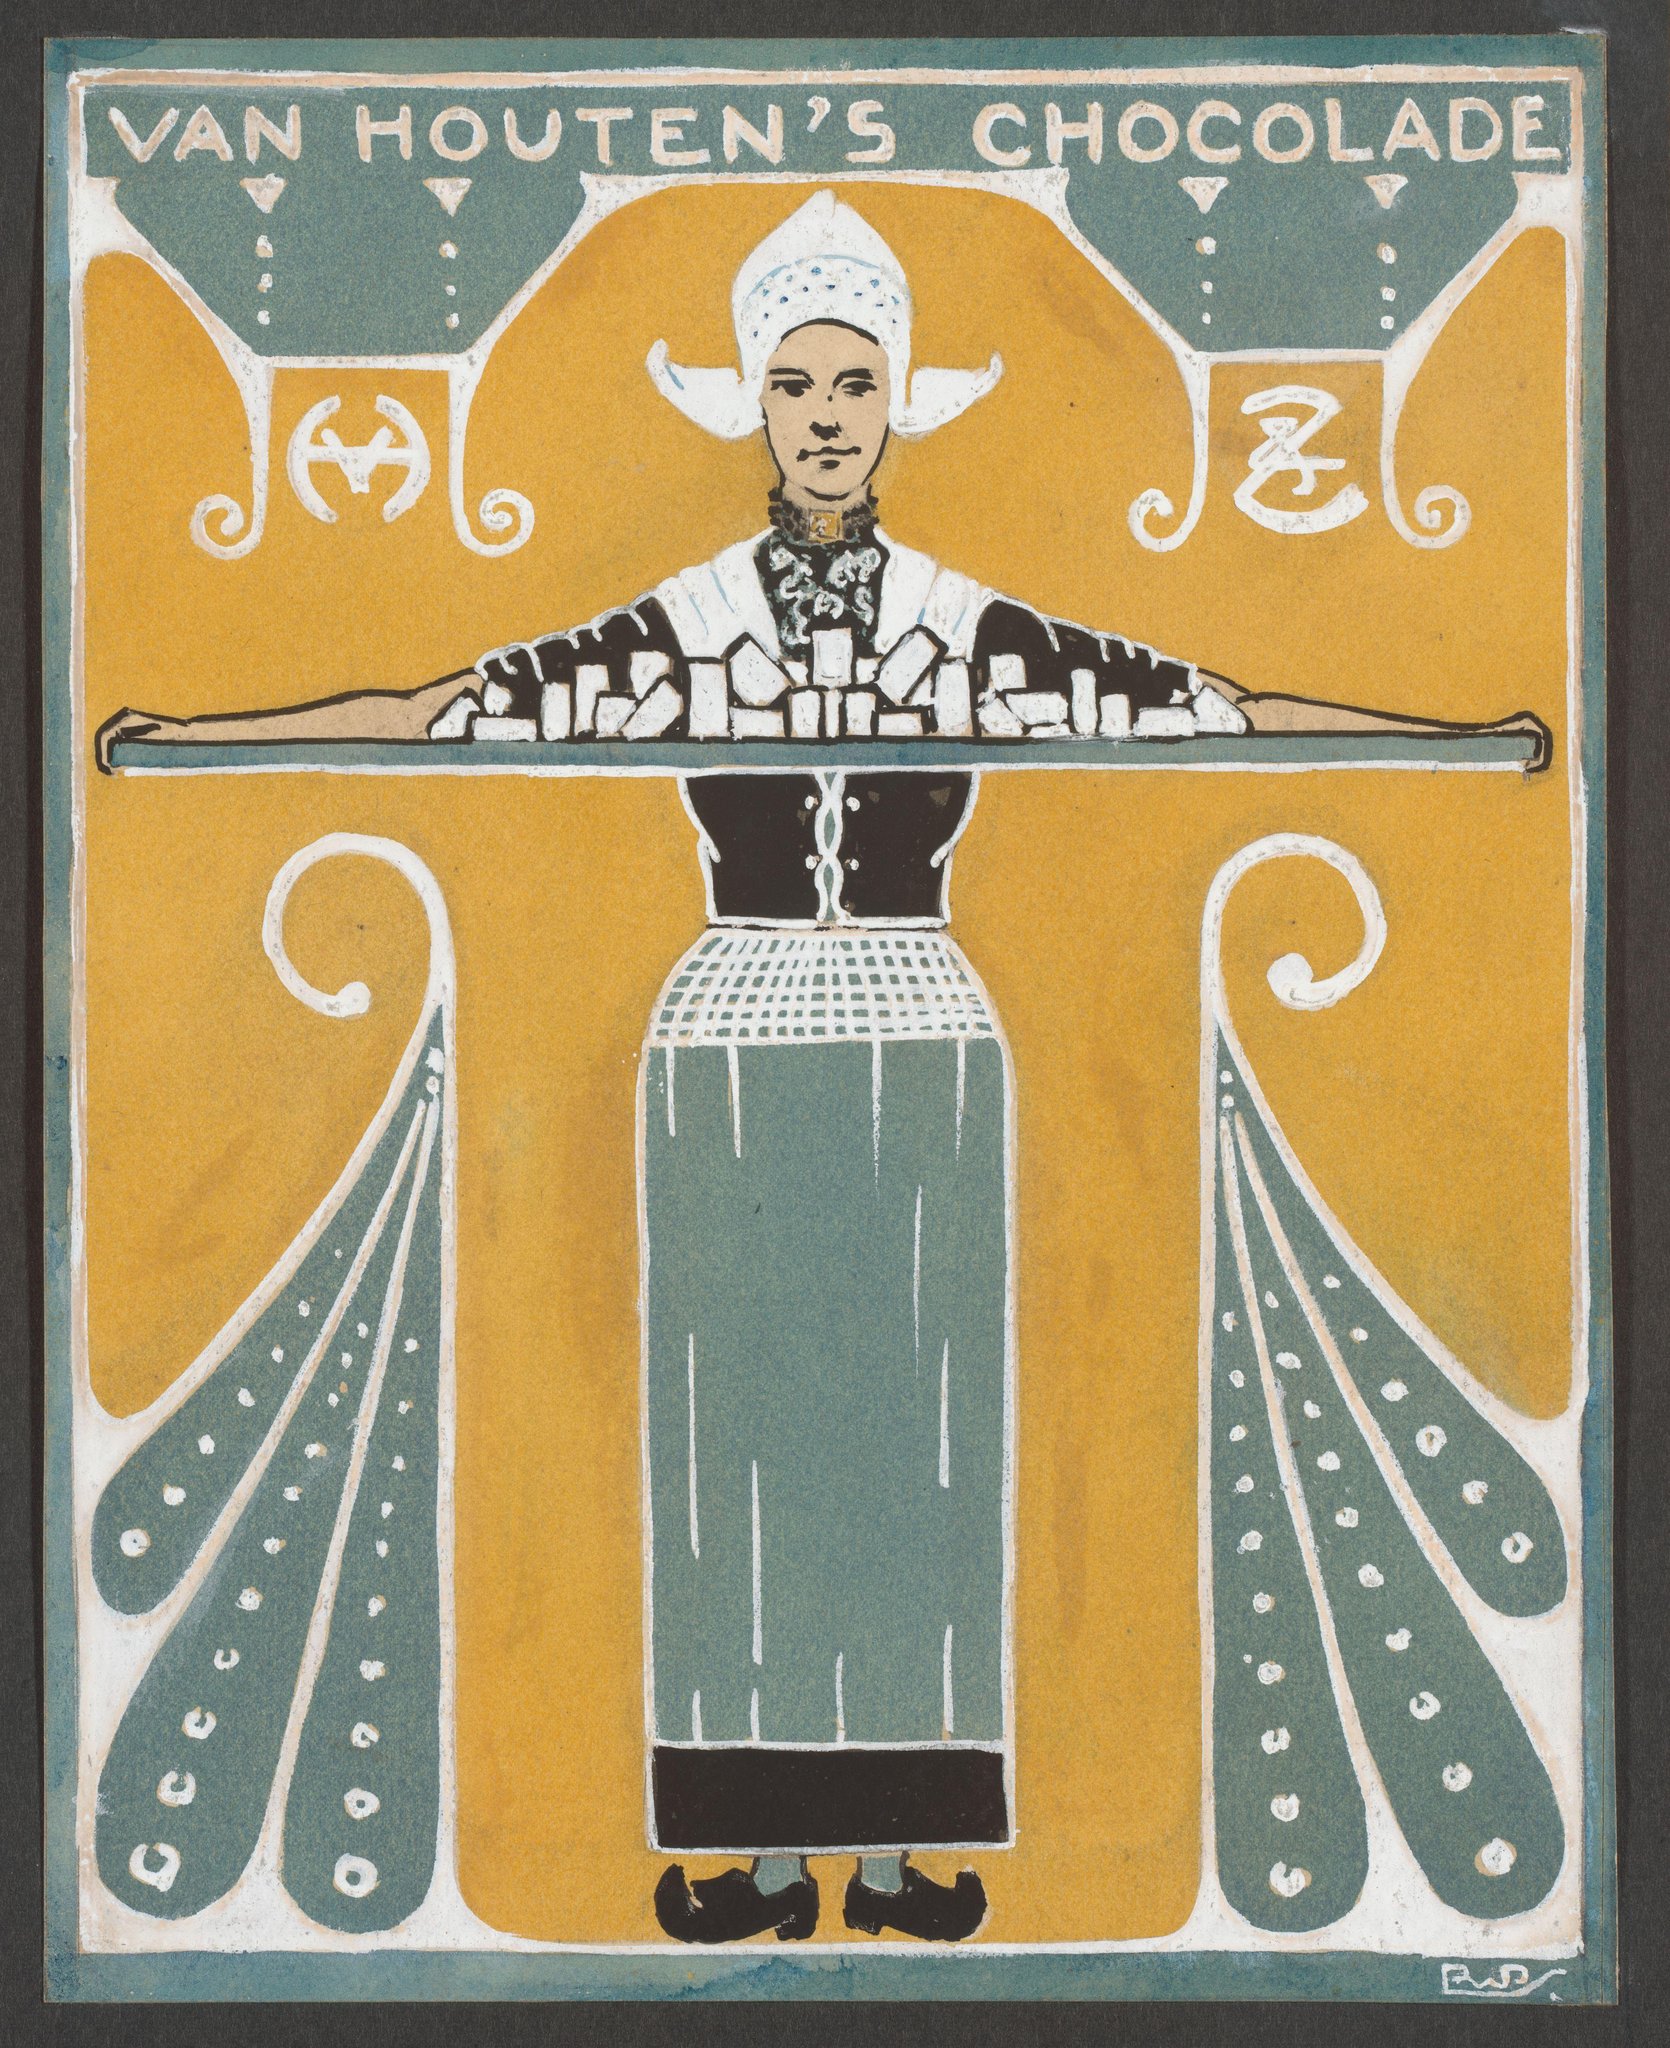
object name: design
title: Ontwerp voor een advertentie voor Van Houten's Chocolade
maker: reinier willem petrus de vries (1874-1953)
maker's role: draughtsman, print maker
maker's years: 1874-1953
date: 1884-1952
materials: paint, paper, pencil, watercolor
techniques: brush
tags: chocolate (solid), folk costume, regional costume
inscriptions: number: ‘No8’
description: Een meisje in klederdracht draagt een dienblad met chocolade.